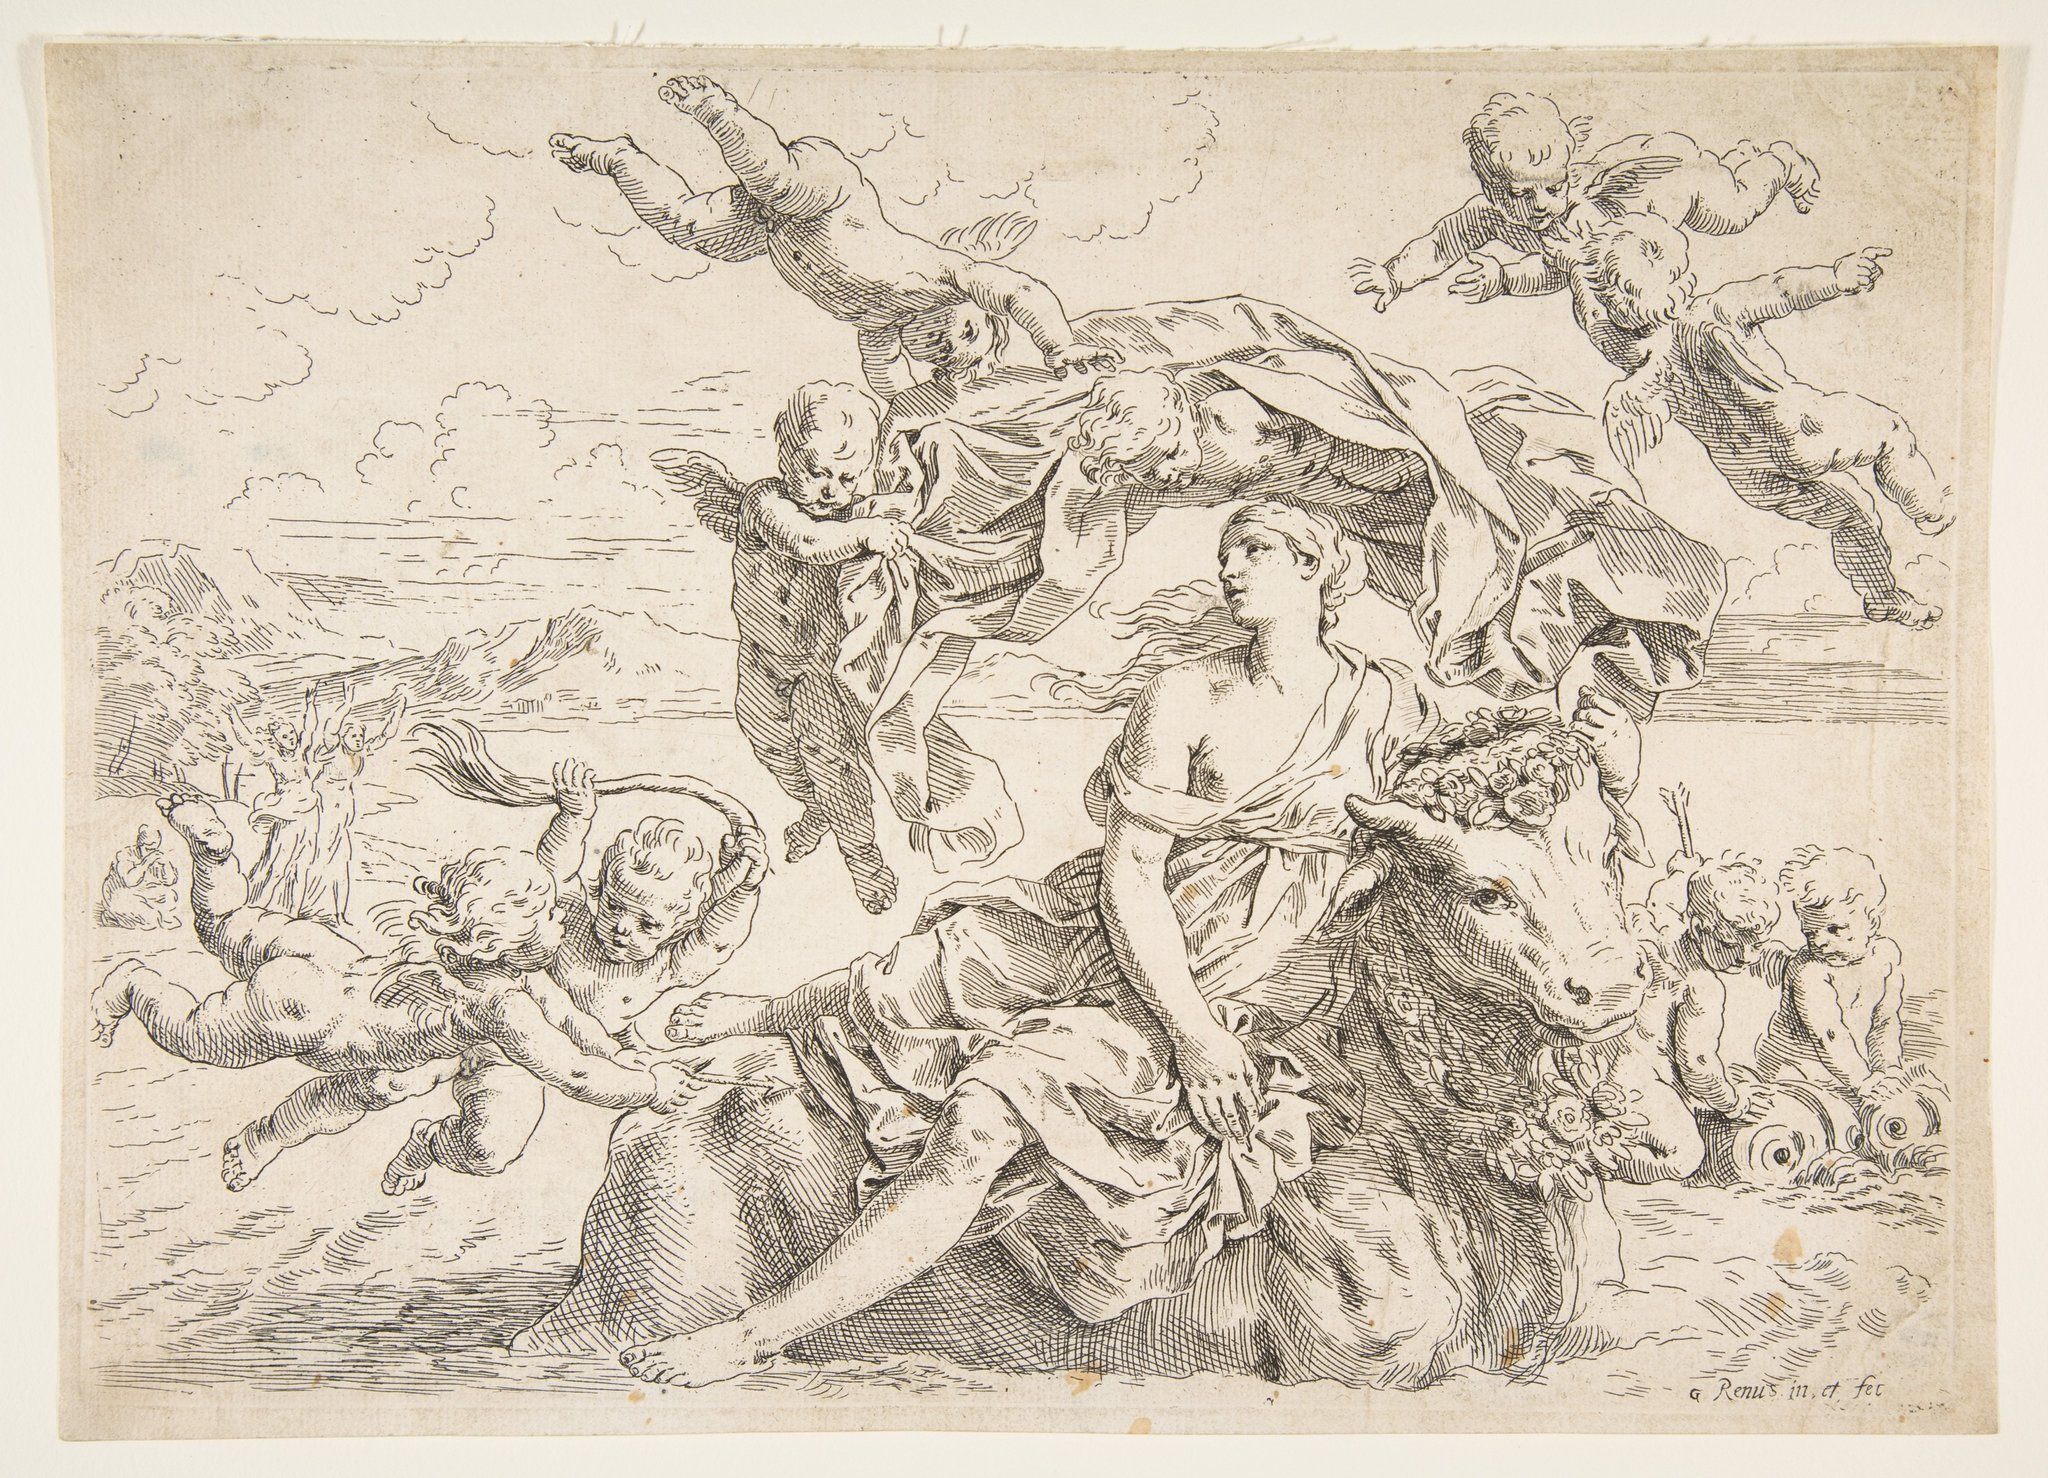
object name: print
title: Rape of Europa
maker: simone cantarini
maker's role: artist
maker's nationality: italian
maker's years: 1612-1648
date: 1636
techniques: drypoint, etching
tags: cupid,europa,bulls